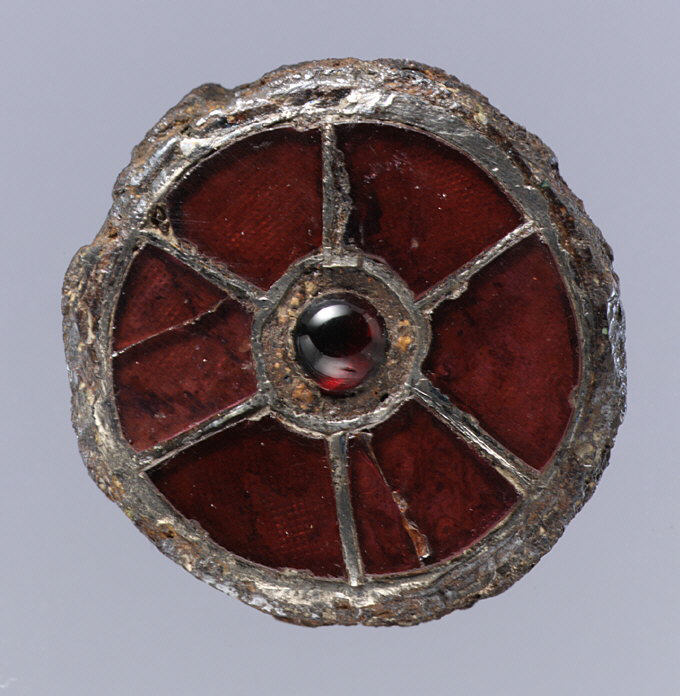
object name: brooch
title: Disk Brooch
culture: frankish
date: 501-600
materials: foil, gemstone, garnet, silver